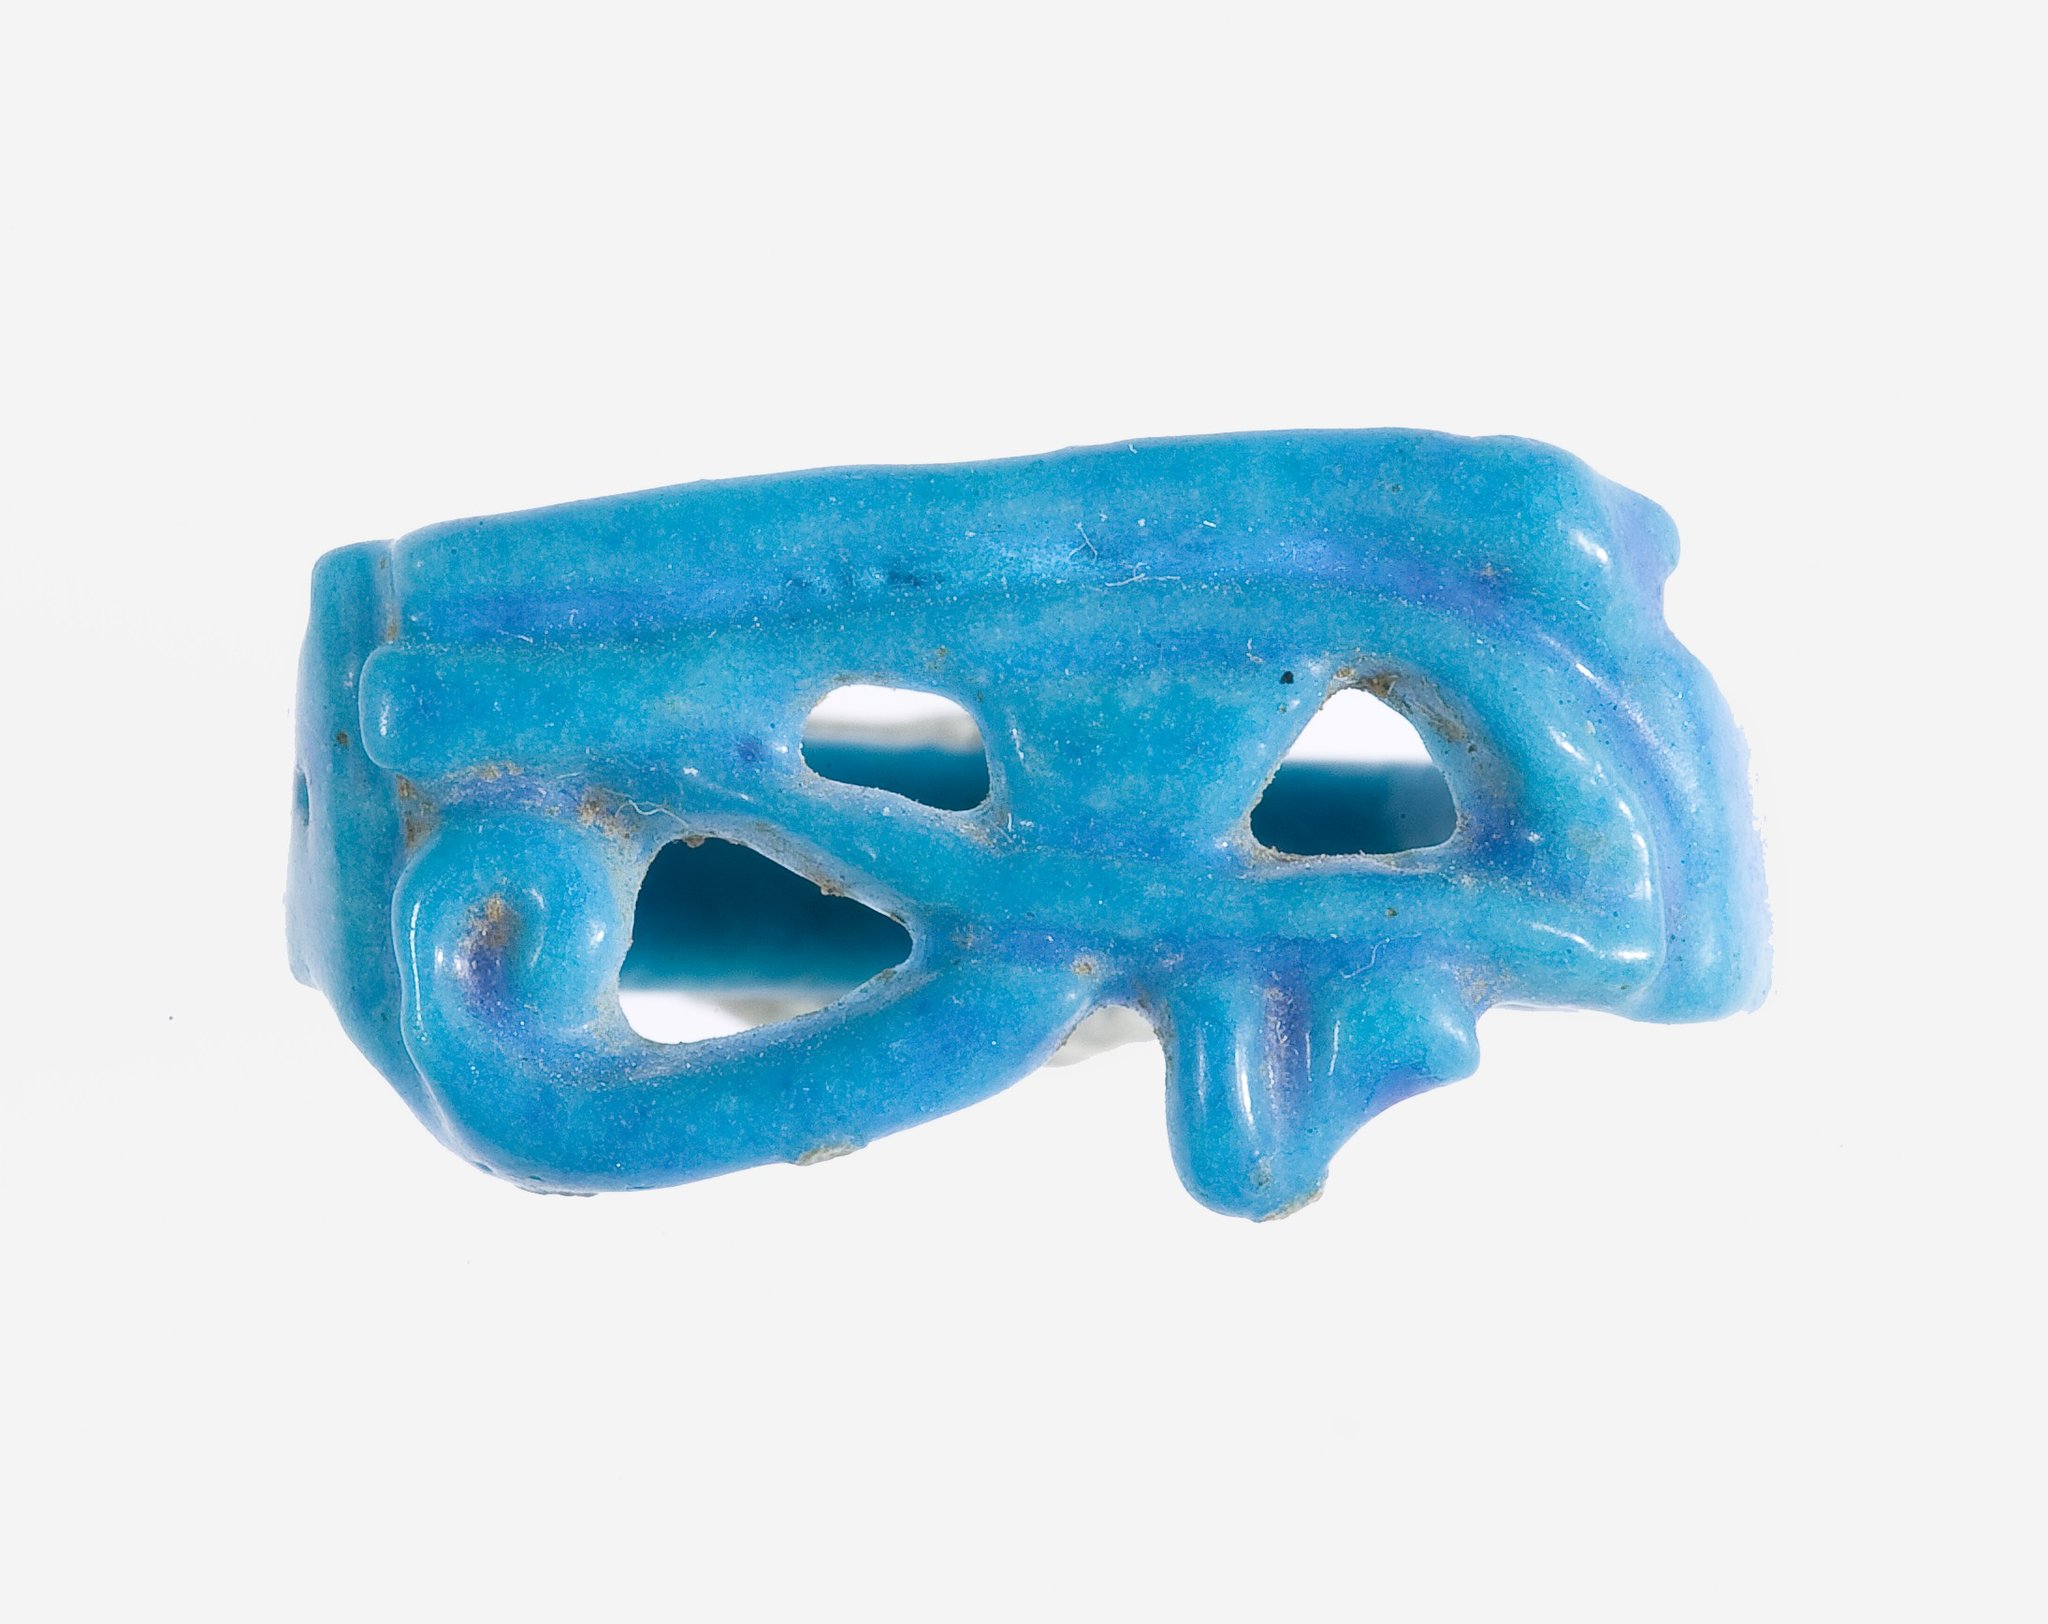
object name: ring, wedjat eye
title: Wedjat Eye Ring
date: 1390-1352 BCE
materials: faience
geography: egypt